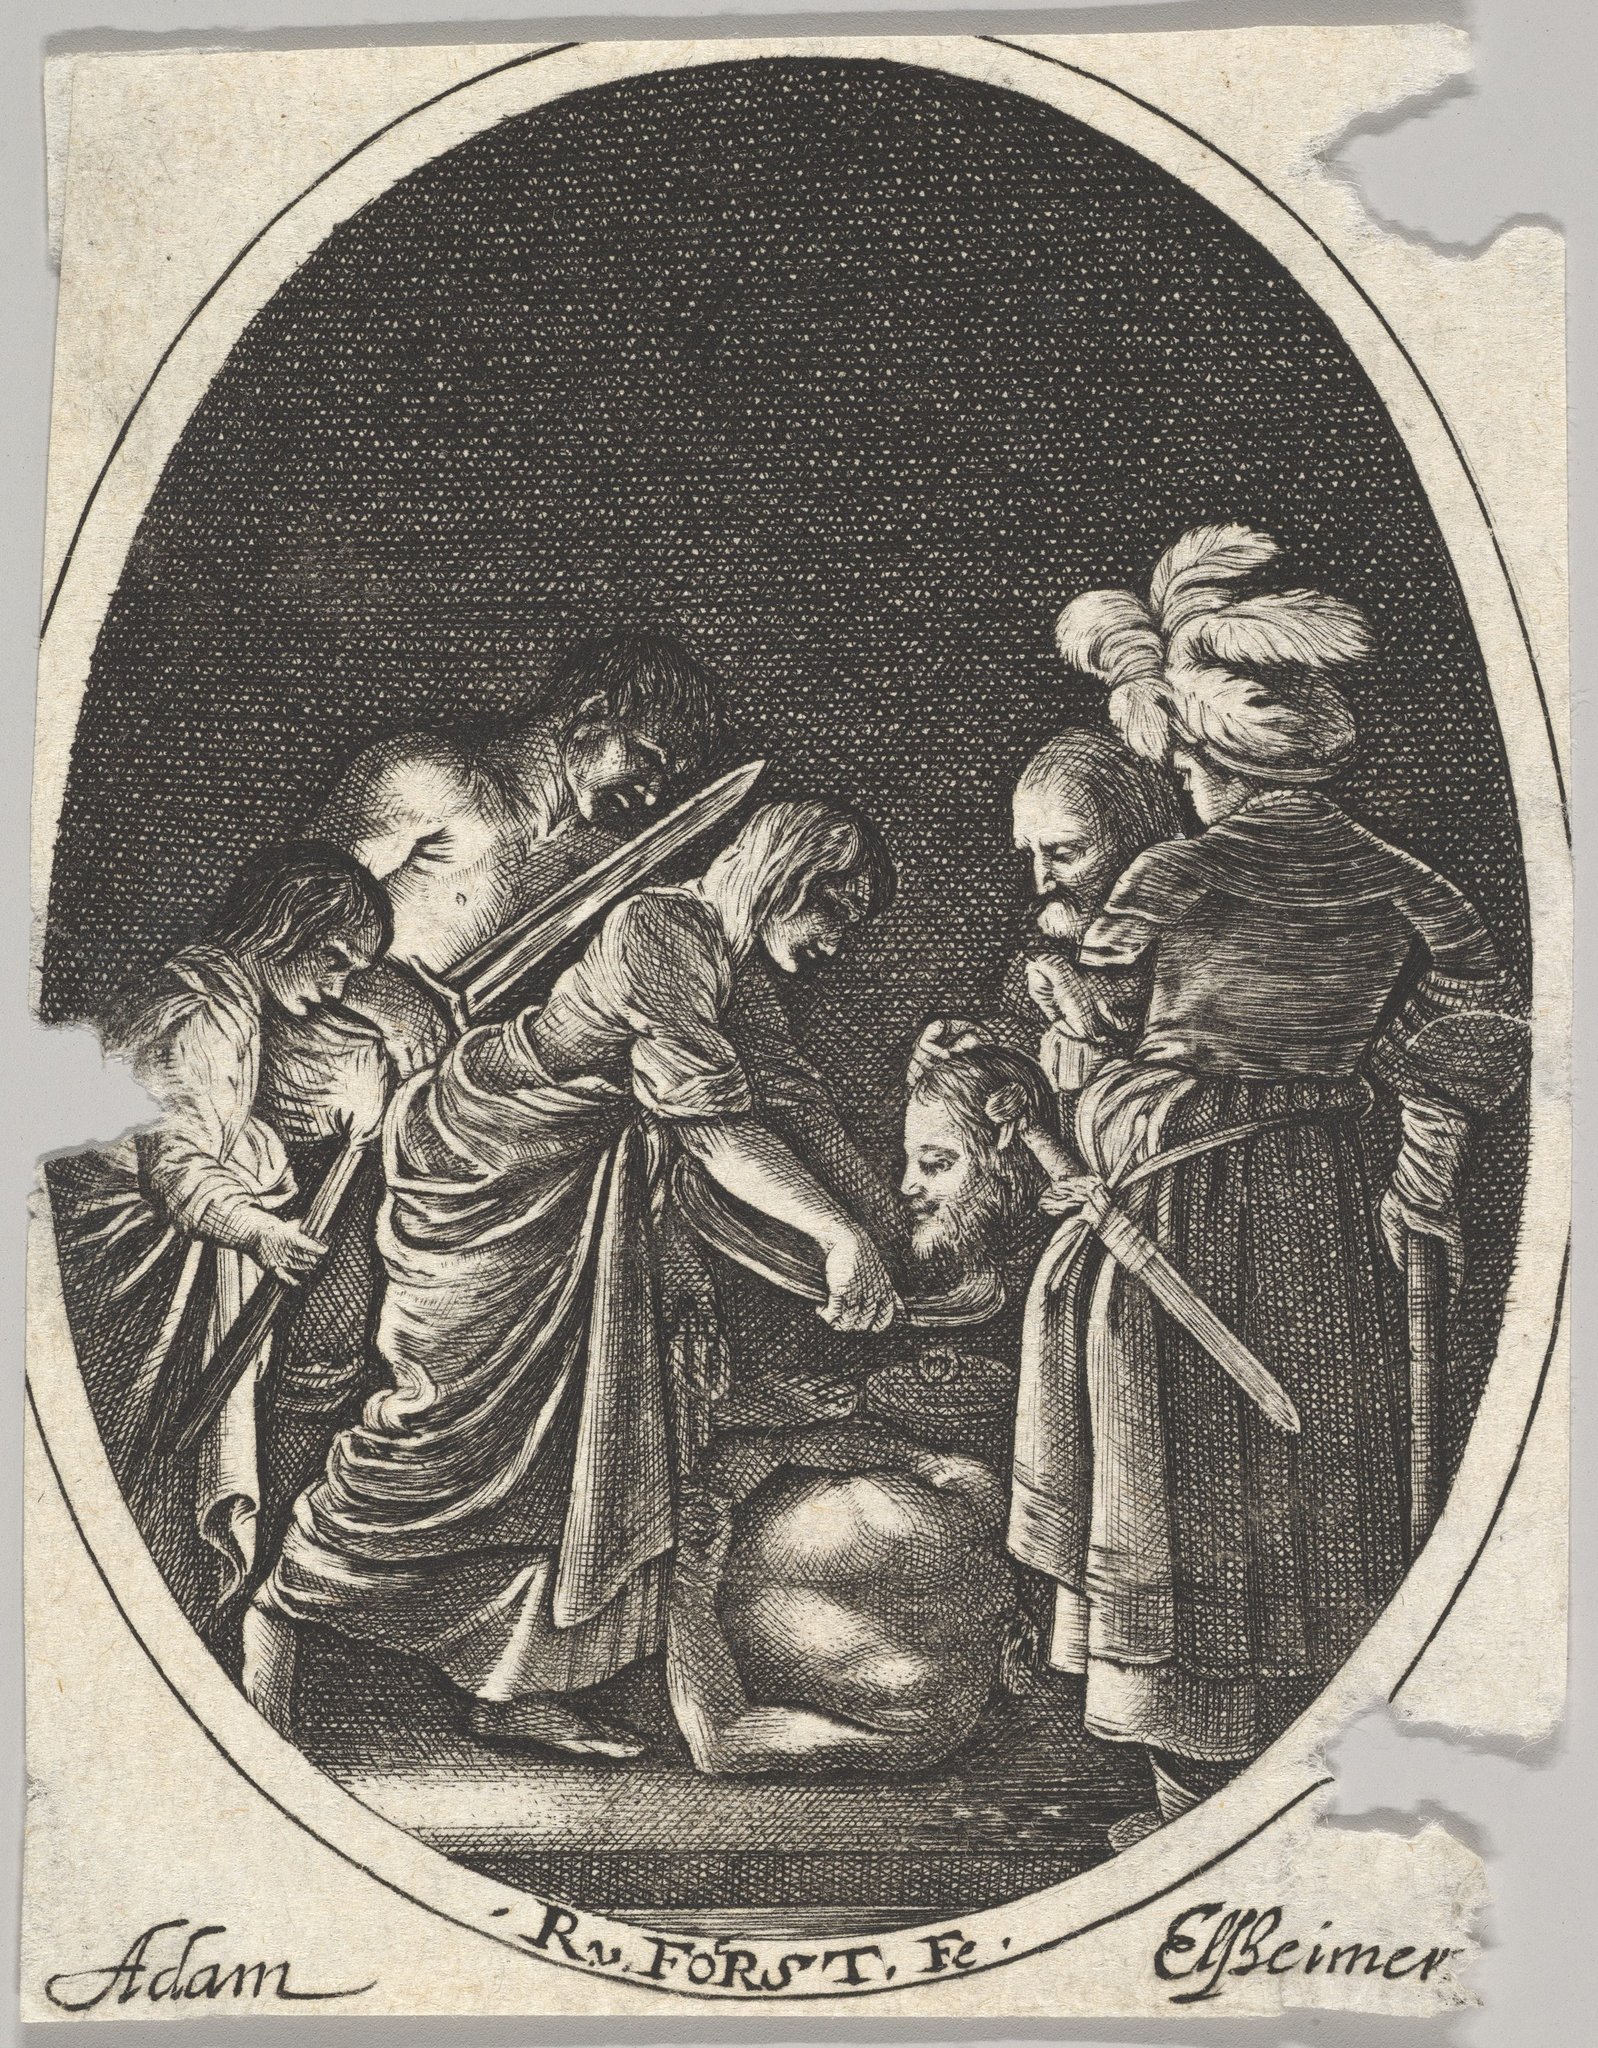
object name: print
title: Salome receiving the head of John the Baptist, surrounded by three men and a child bearing a torch, the Baptist's body lies on the ground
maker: hendrick goudt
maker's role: artist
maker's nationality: dutch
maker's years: 1580-1648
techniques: engraving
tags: swords,heads,men,saint john the baptist